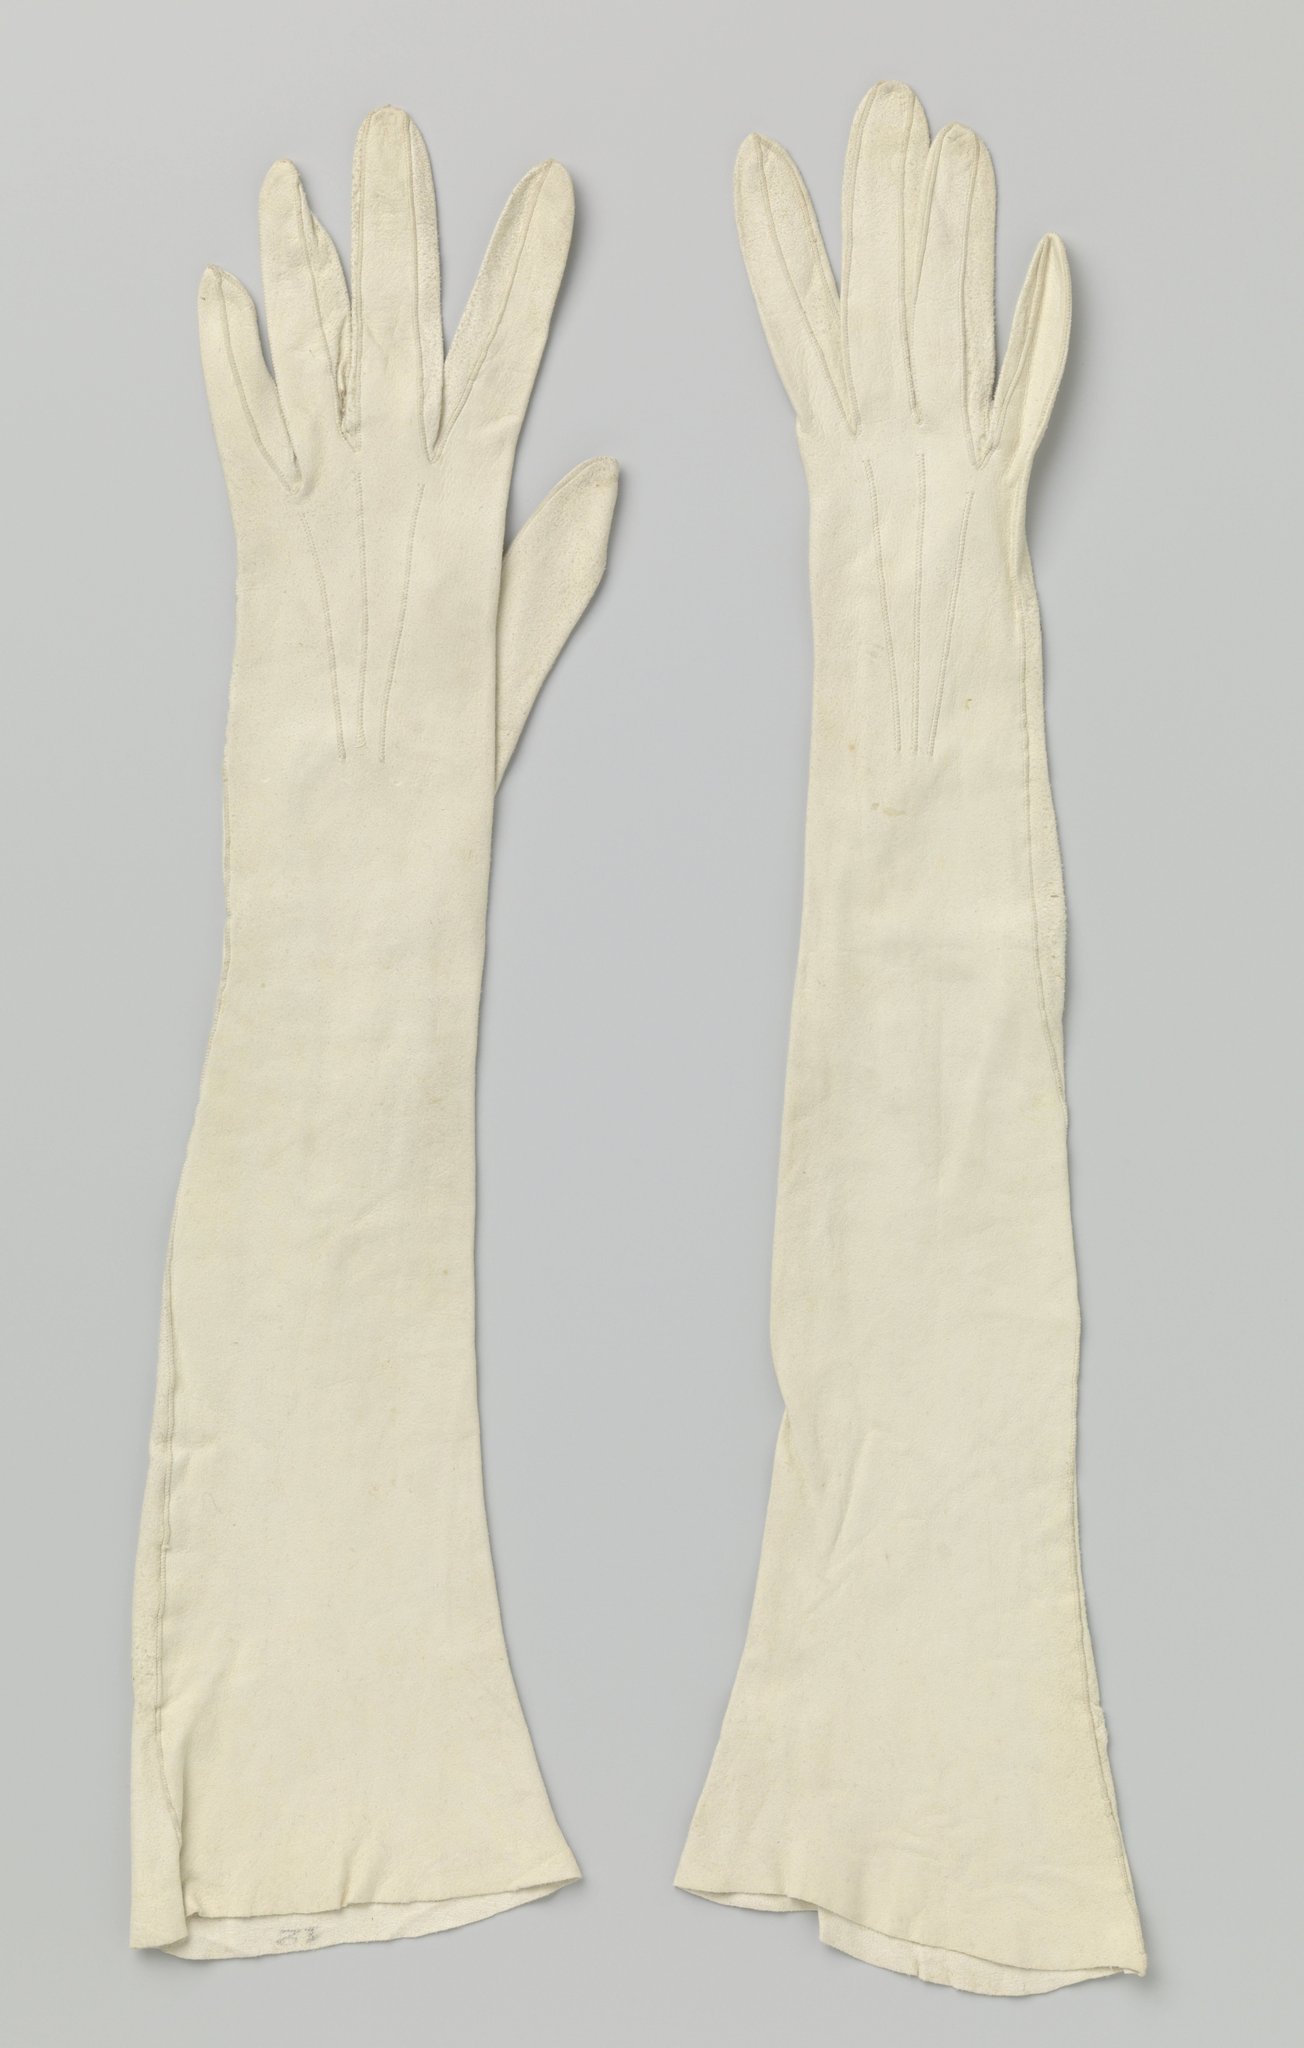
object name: glove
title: Handschoen van wit zeemleer met knoopsluiting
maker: Anonymous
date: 1900-1925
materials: leather, mother of pearl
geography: france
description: Linkerhandschoen van zeemleer. Bij de pols een split, afgezet met wit leer en drie parelmoeren platte knopen. Adres (grotendeels weggewassen): Grand Prix Paris 1900.